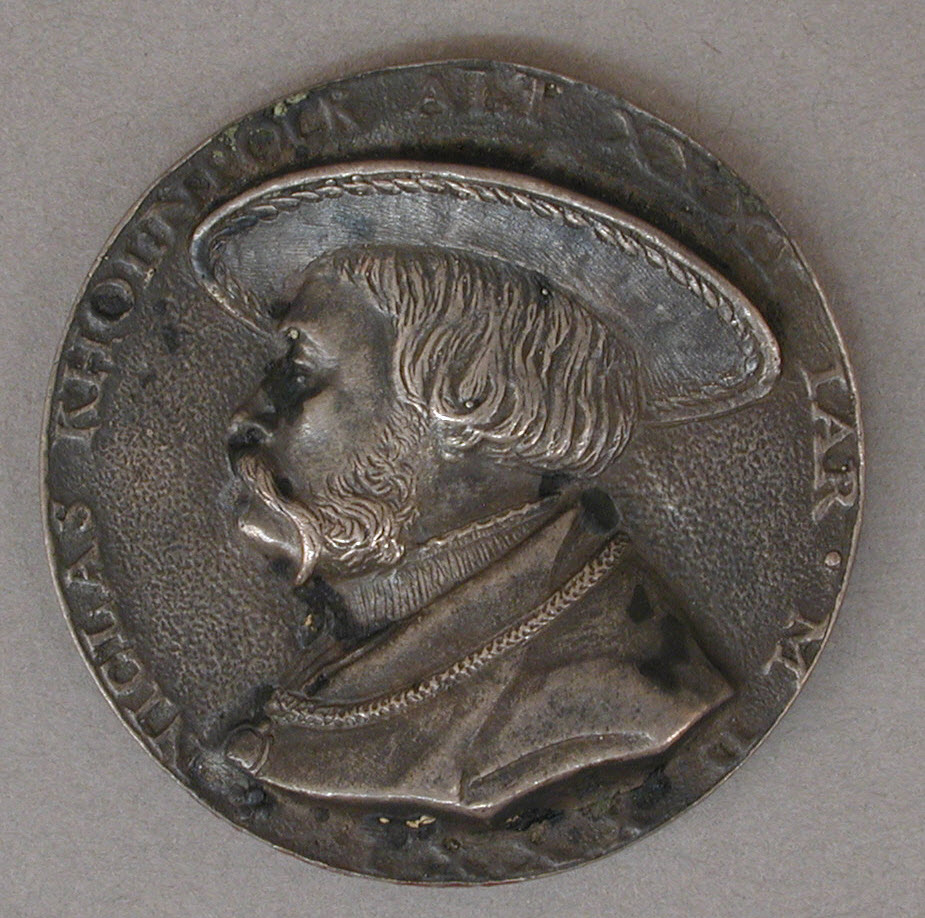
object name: medal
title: Niclas Khonpolk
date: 1531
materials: silver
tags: men,profiles,female nudes